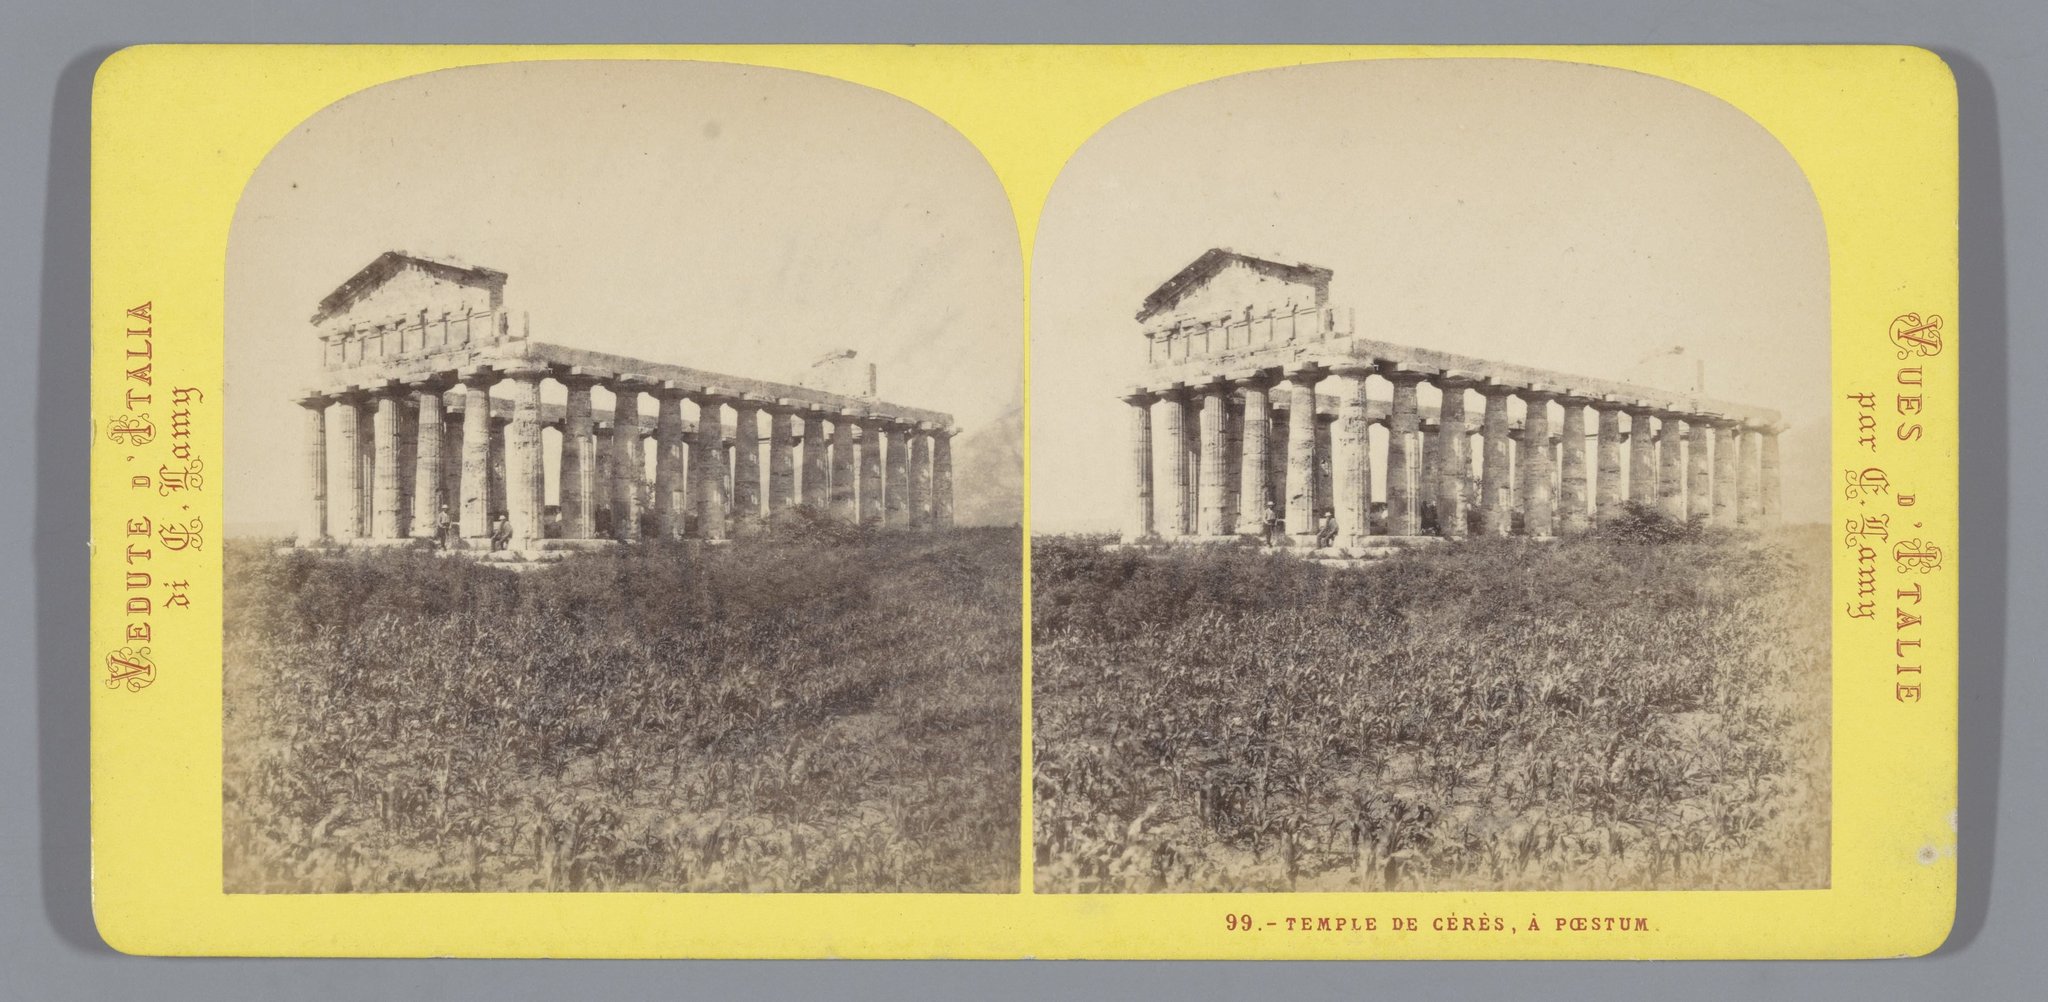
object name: stereograph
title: Temple de Cérès, à Pœstum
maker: ernest eléonor pierre lamy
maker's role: publisher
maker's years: 1828-1900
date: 1861-1878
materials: cardboard, paper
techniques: albumen print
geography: paestum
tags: temple, shrine ~ greek religion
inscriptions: number: ‘99.’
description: Men heeft lange tijd ten onrechte aangenomen dat dit de Tempel van Ceres is geweest.